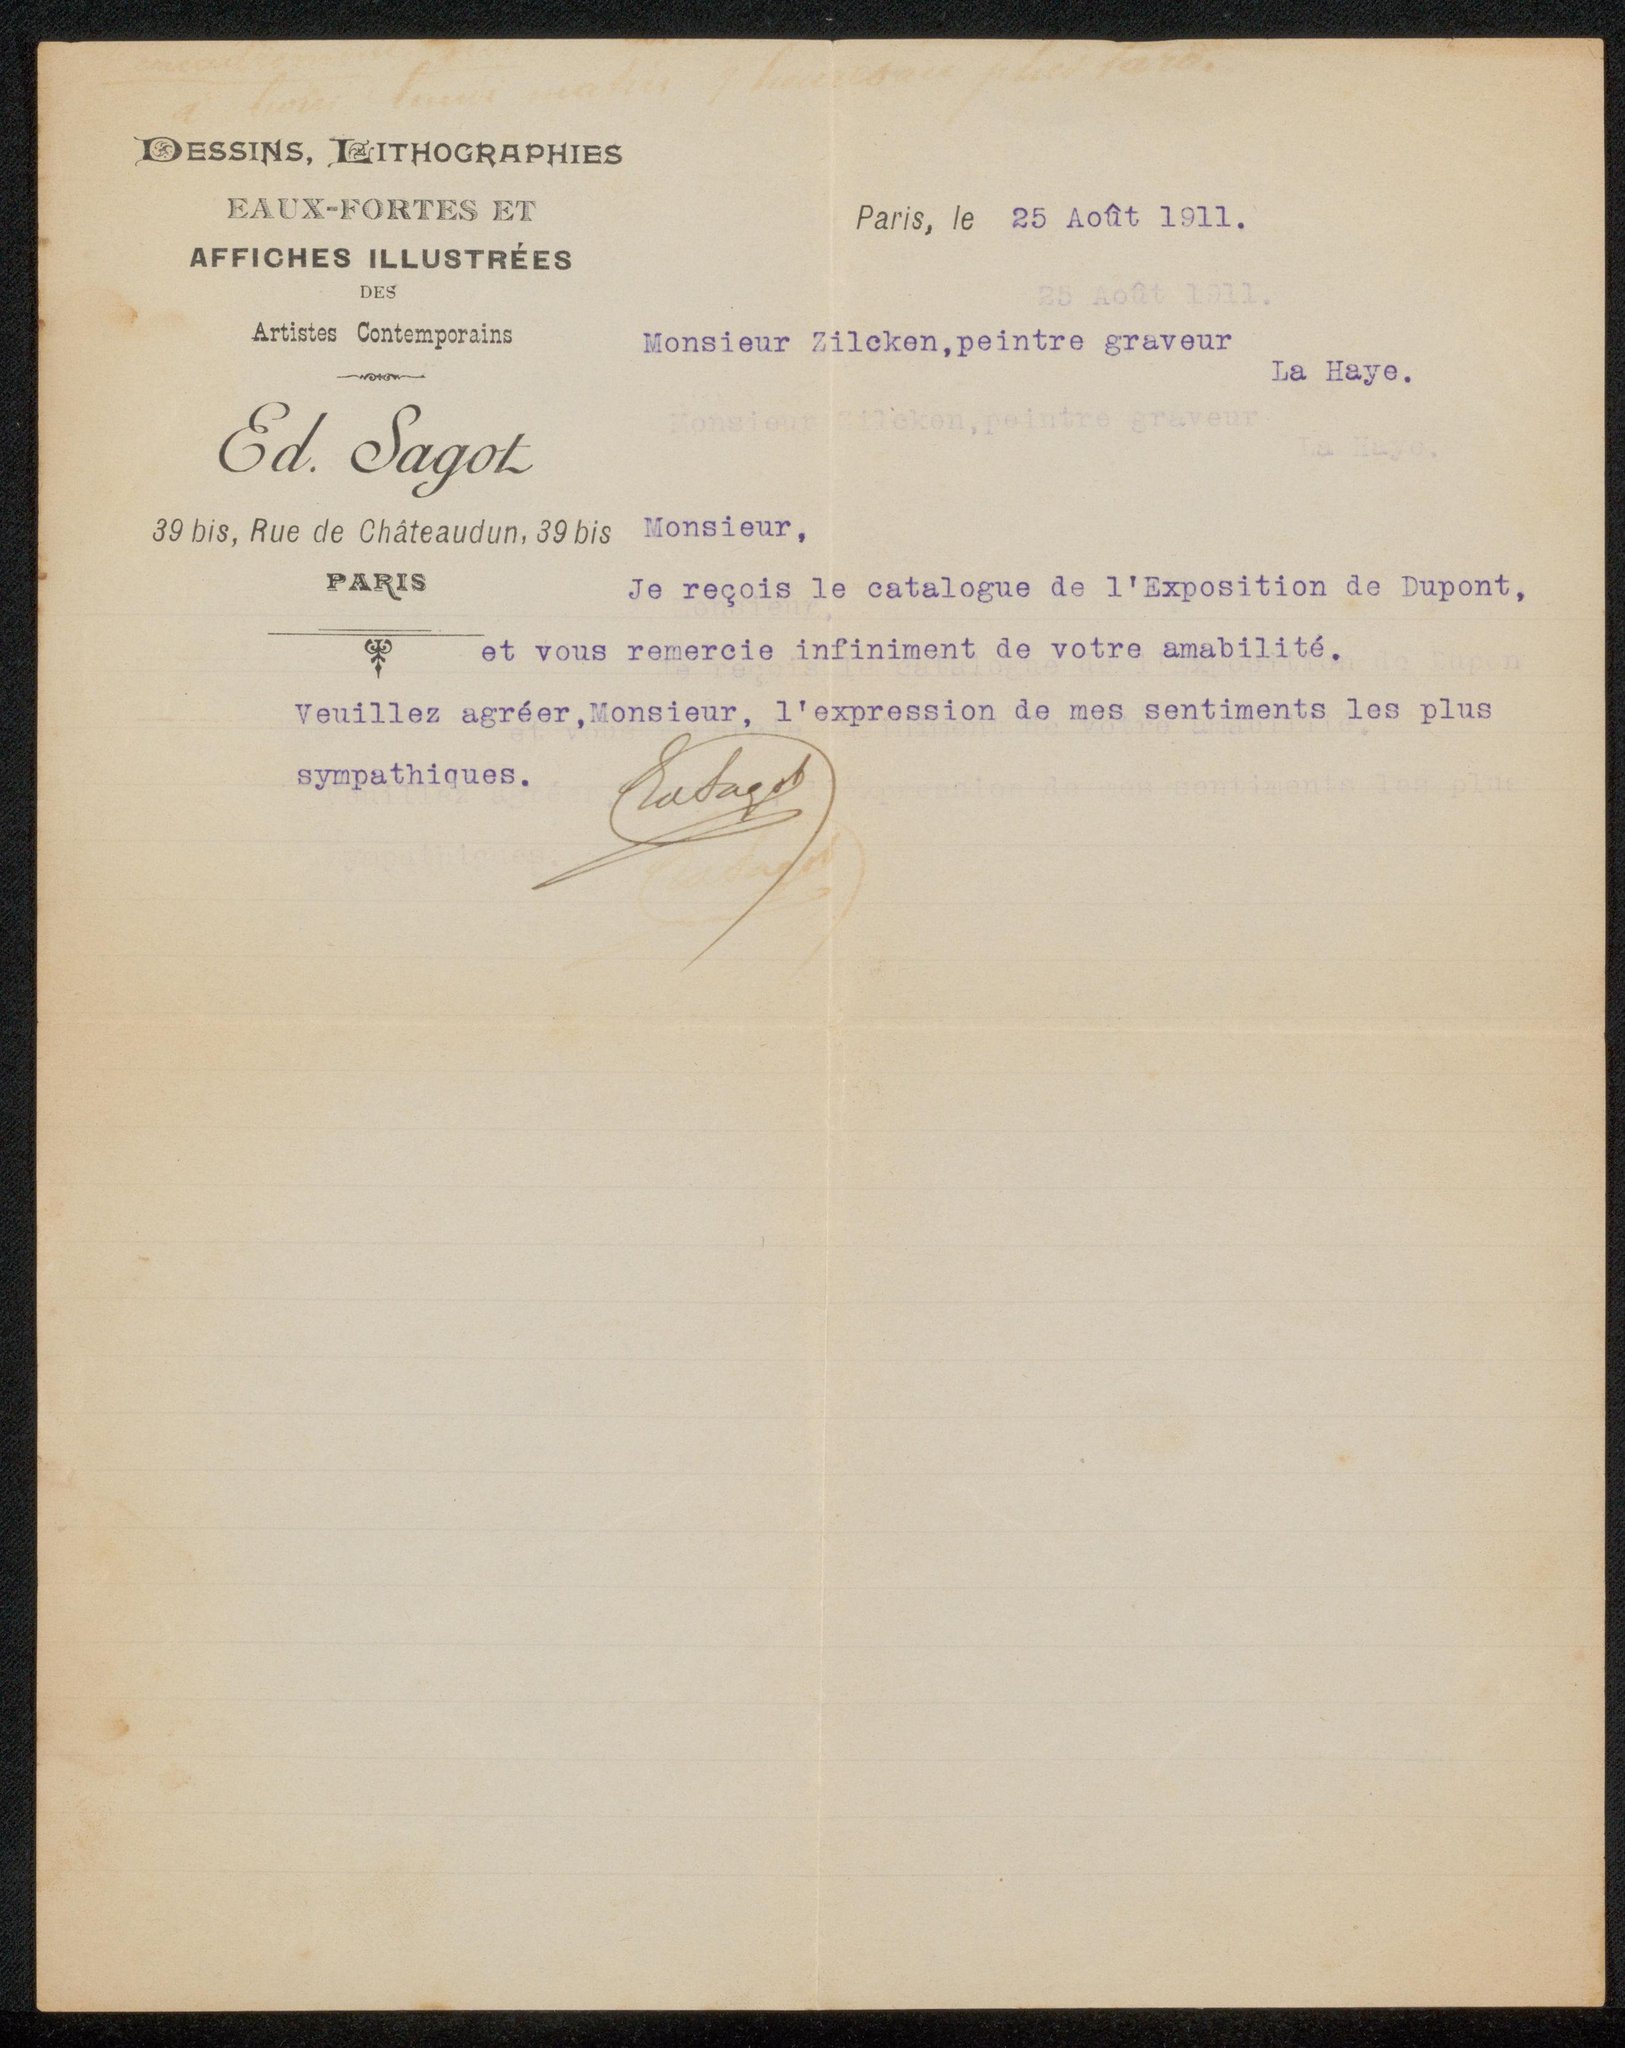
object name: letter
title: Brief aan Philip Zilcken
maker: edmond sagot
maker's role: publisher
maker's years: 1857-1917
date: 1911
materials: ink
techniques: pen, printing, typewriting, writing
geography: paris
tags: print maker, draughtsman, pieter dupont, the hague, philip zilcken, exhibition ~ art, printed matter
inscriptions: collector's mark: ‘RPK’